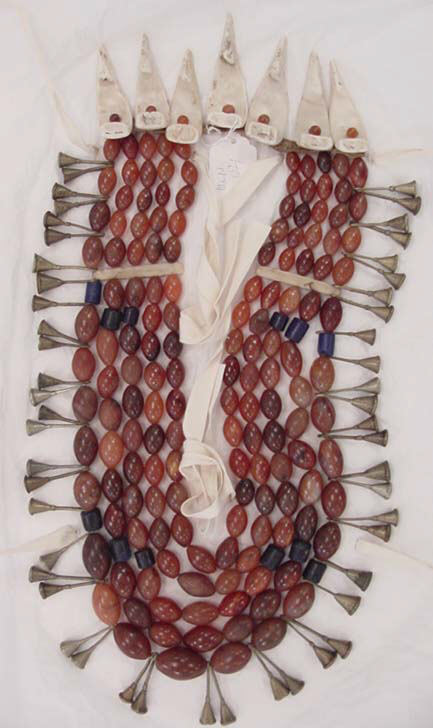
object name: necklace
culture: naga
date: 1801-1900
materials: bone, brass, cotton, stone